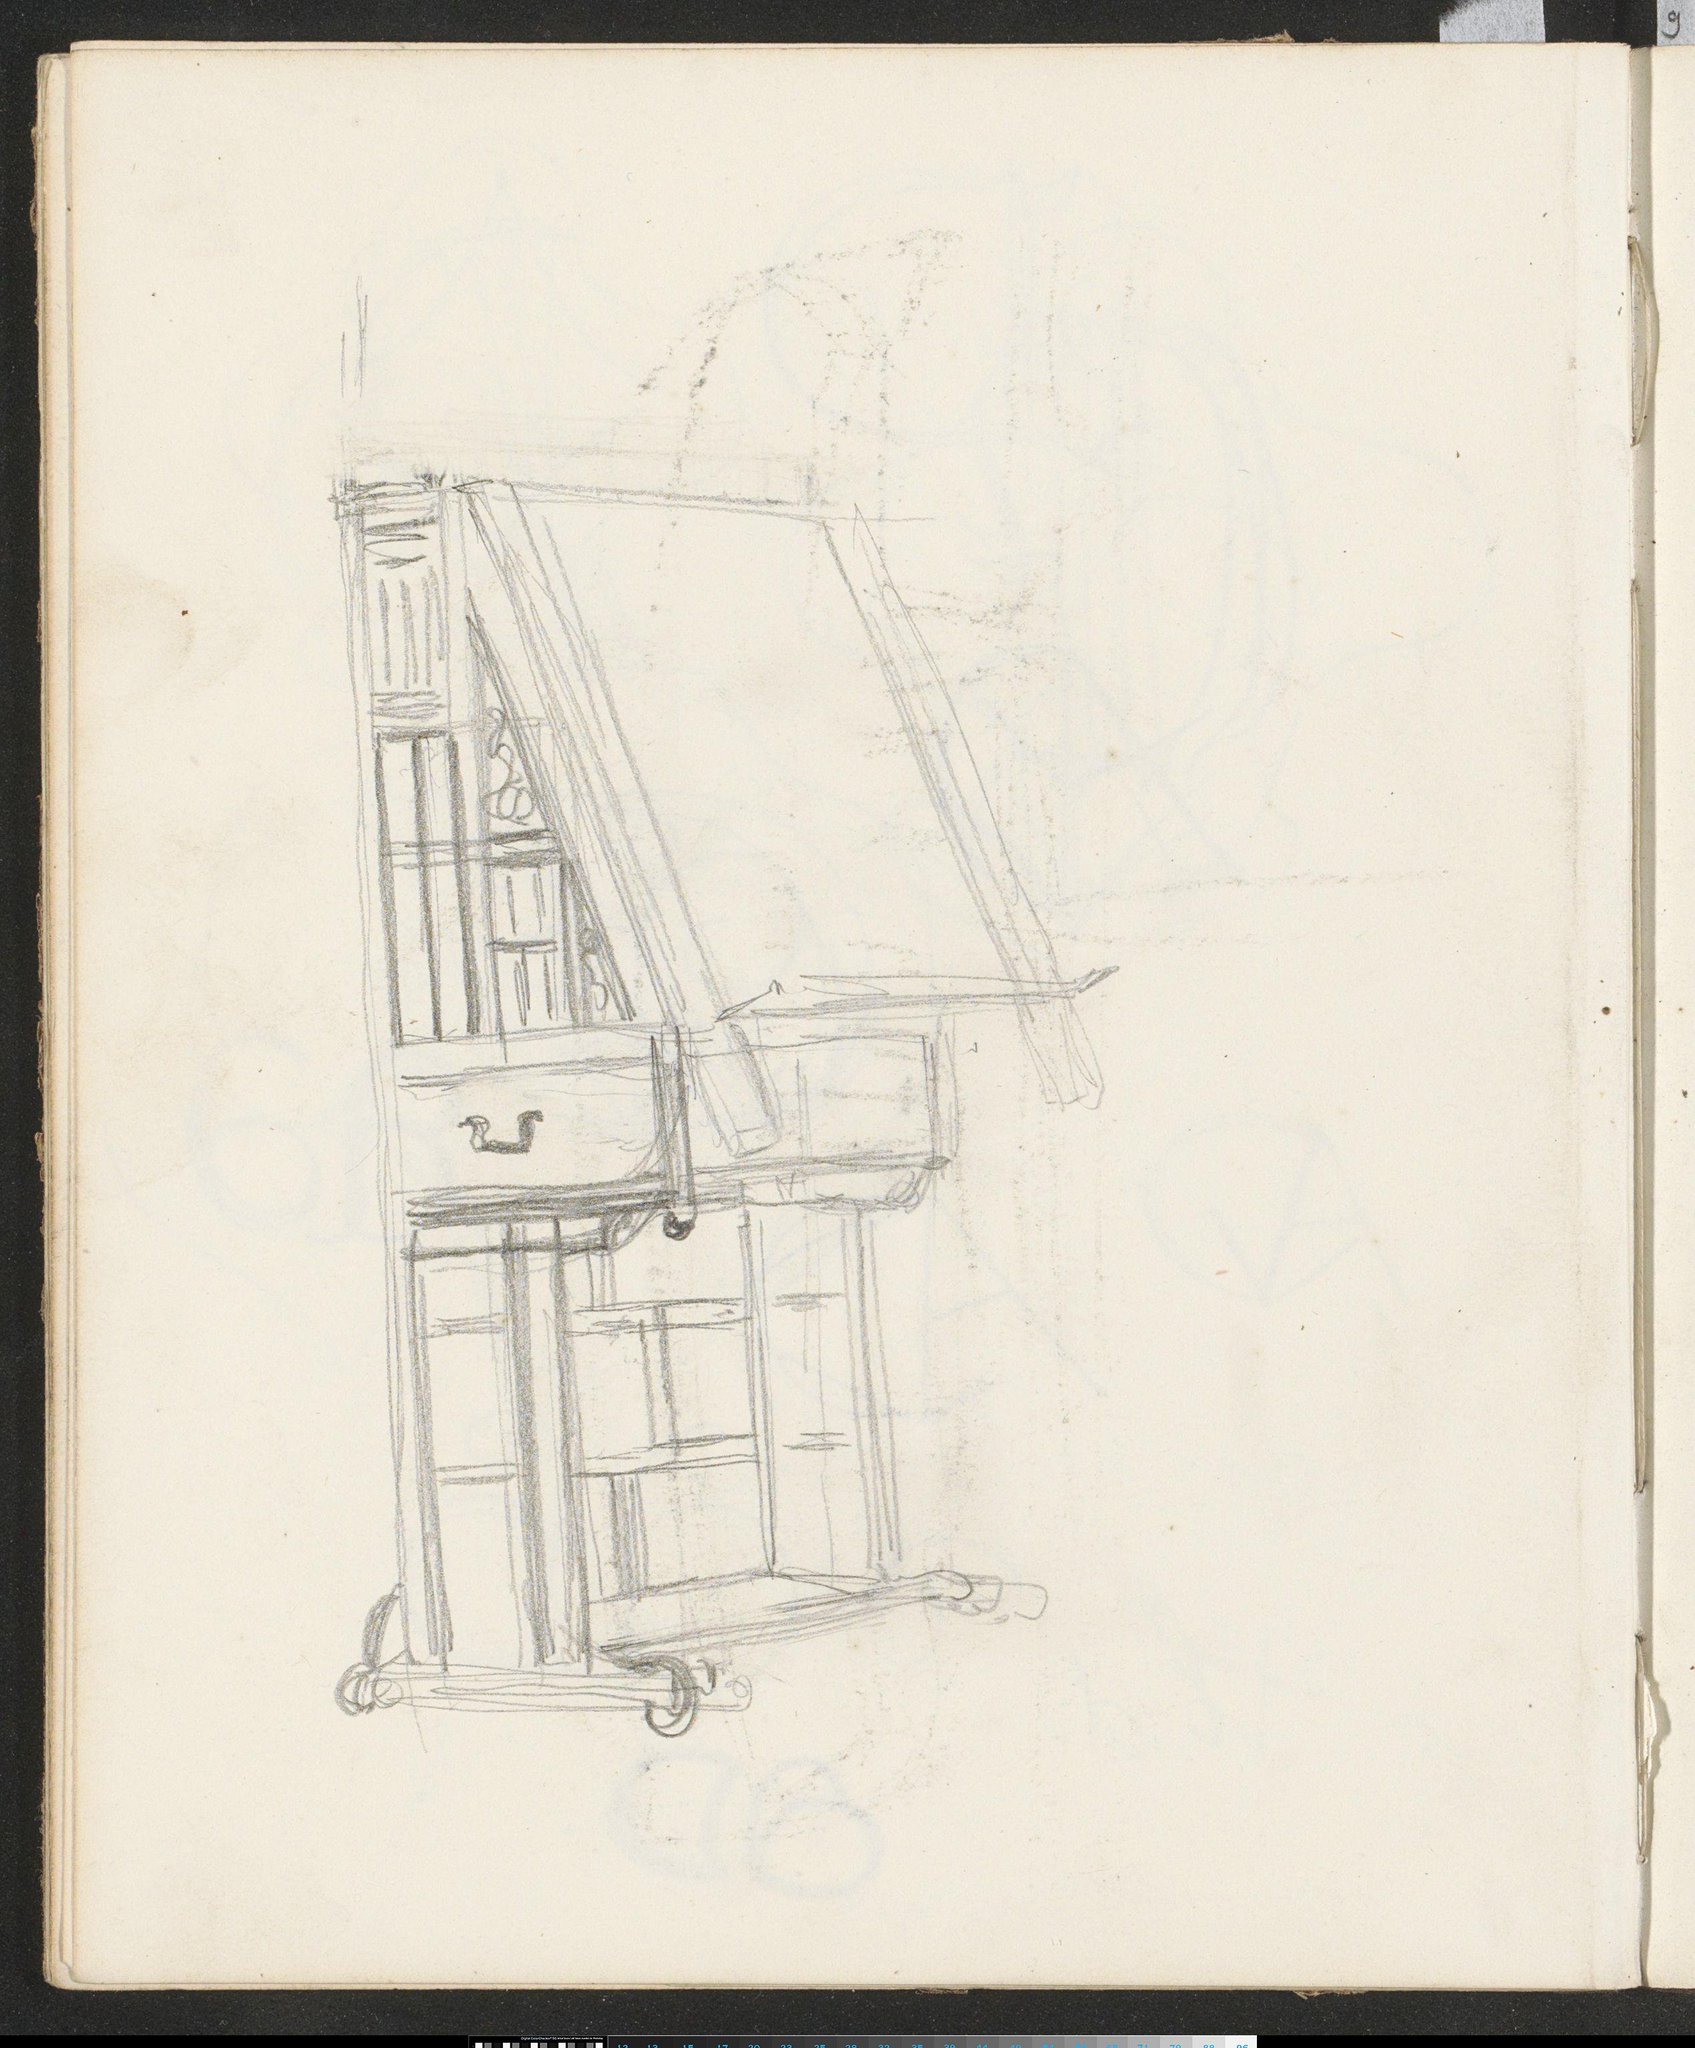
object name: sketchbook leaf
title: Ontwerp voor een meubel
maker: carel adolph lion cachet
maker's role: draughtsman, print maker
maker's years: 1864-1945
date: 1900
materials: paper, pencil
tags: furniture and household effects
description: Blad 8 verso uit een schetsboek met 15 bladen.